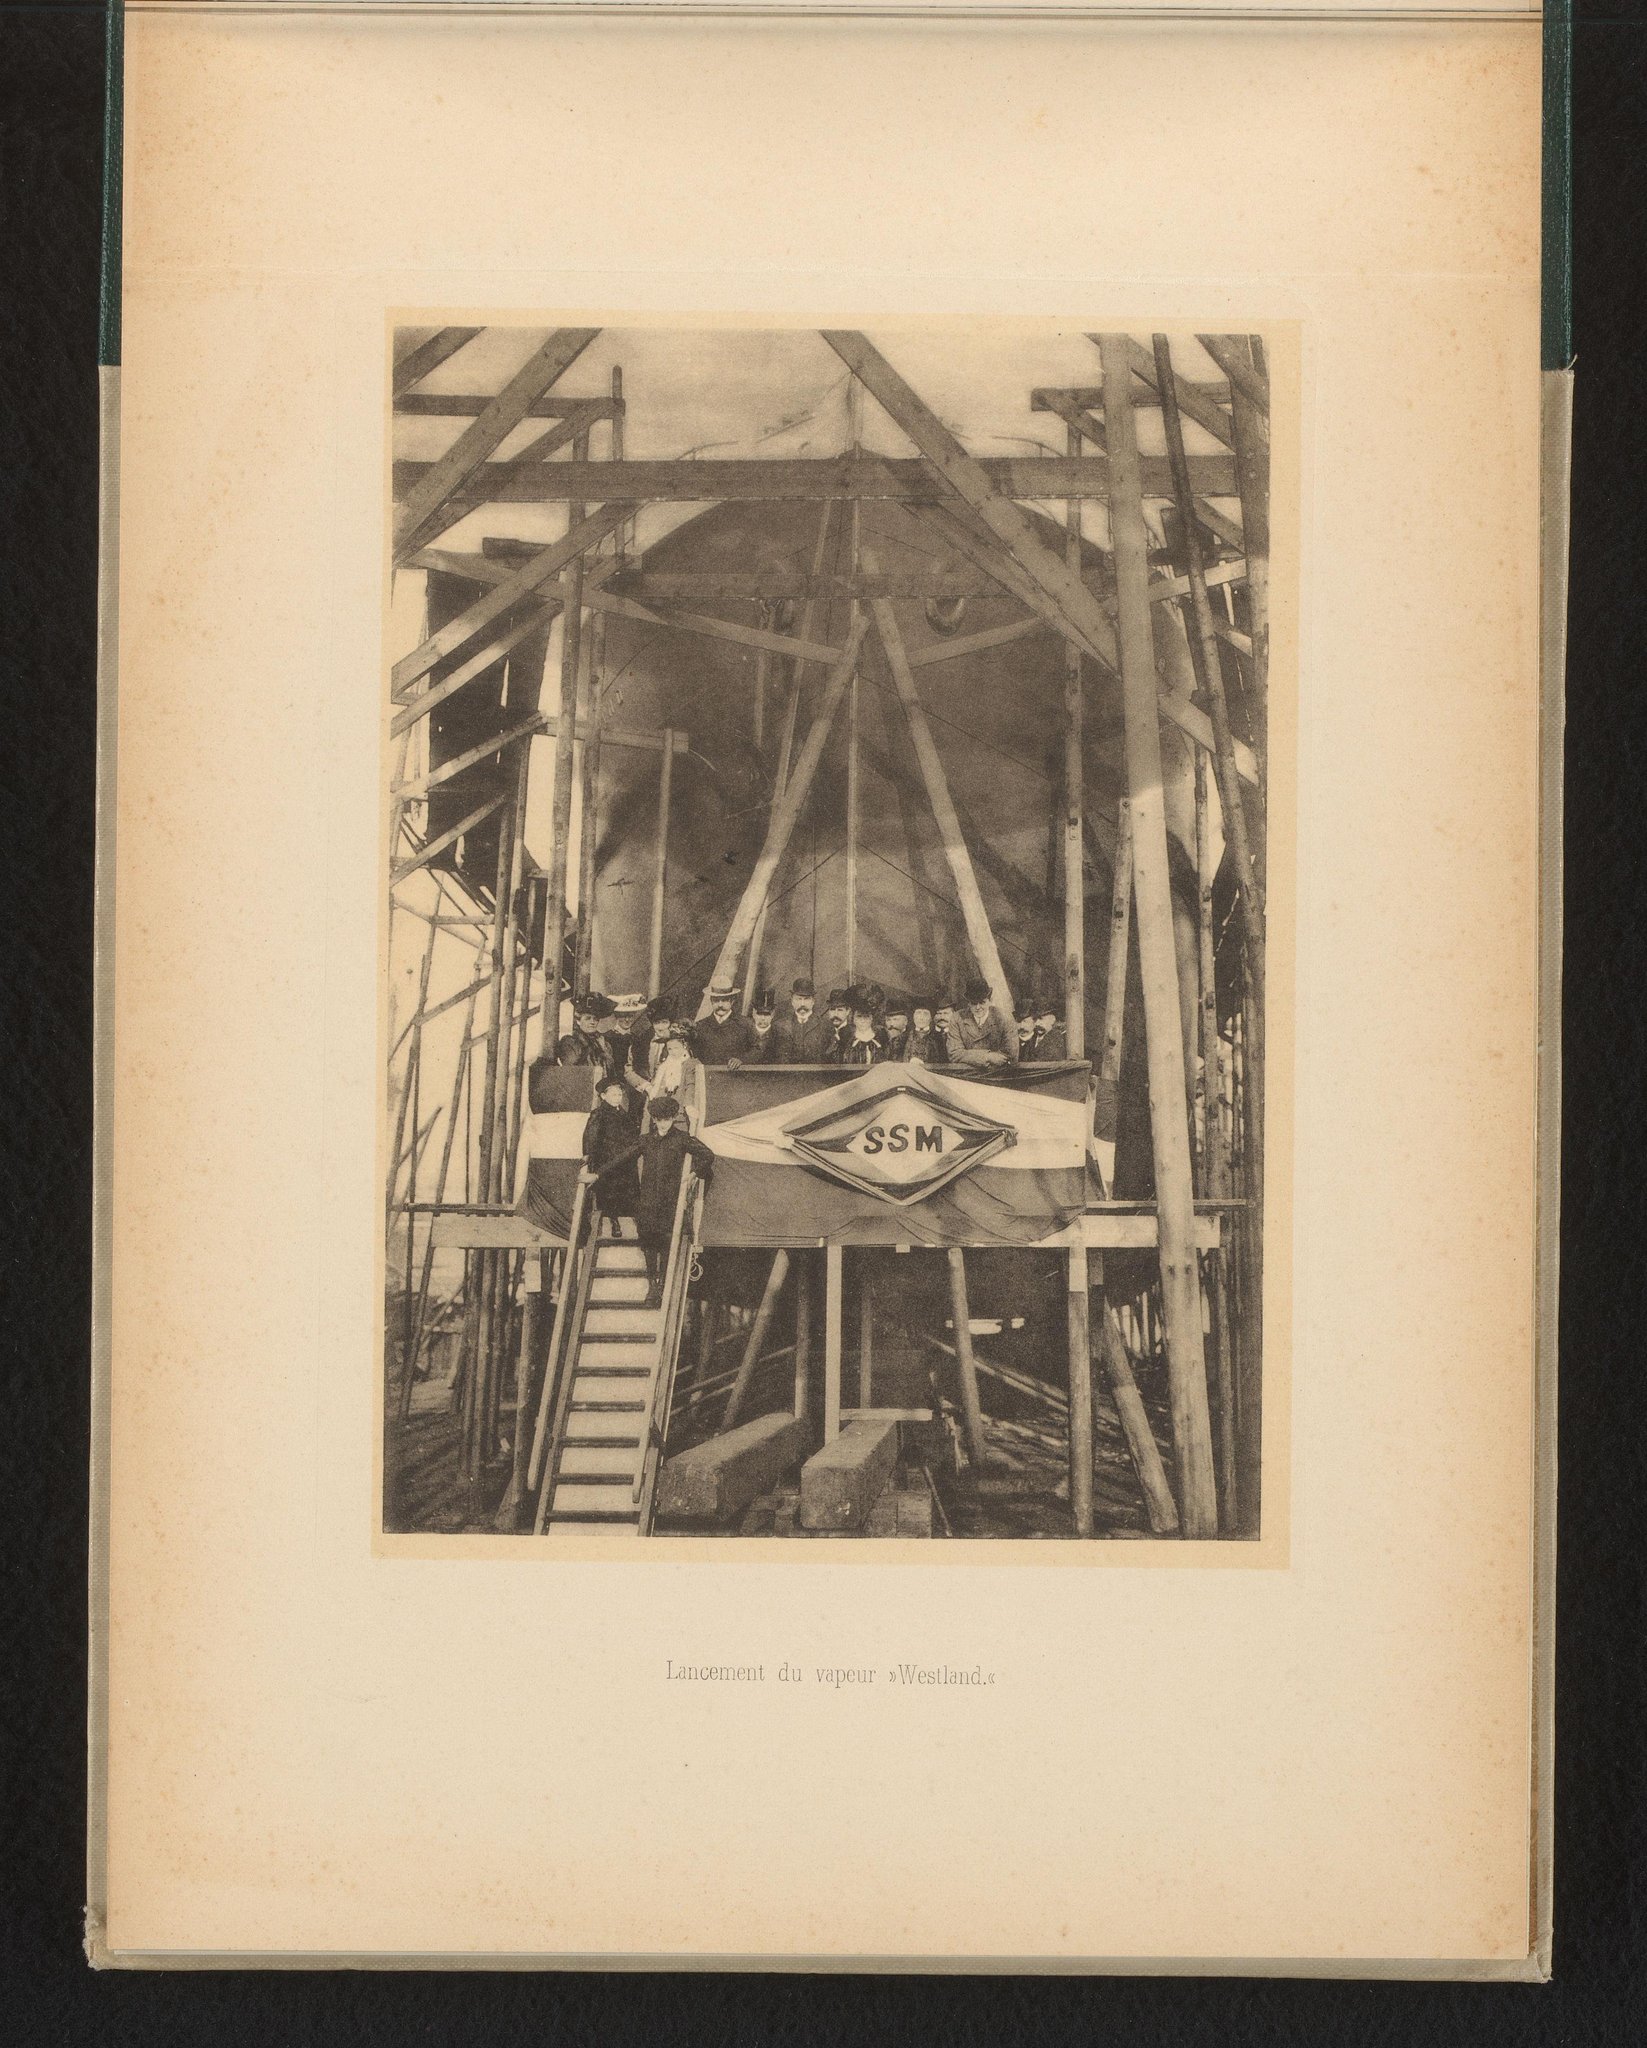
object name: page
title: Tewaterlating van het stoomschip Westland, Rotterdam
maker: Anonymous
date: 1902-1907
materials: paper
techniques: photograph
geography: rotterdam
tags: launching a ship, rotterdam